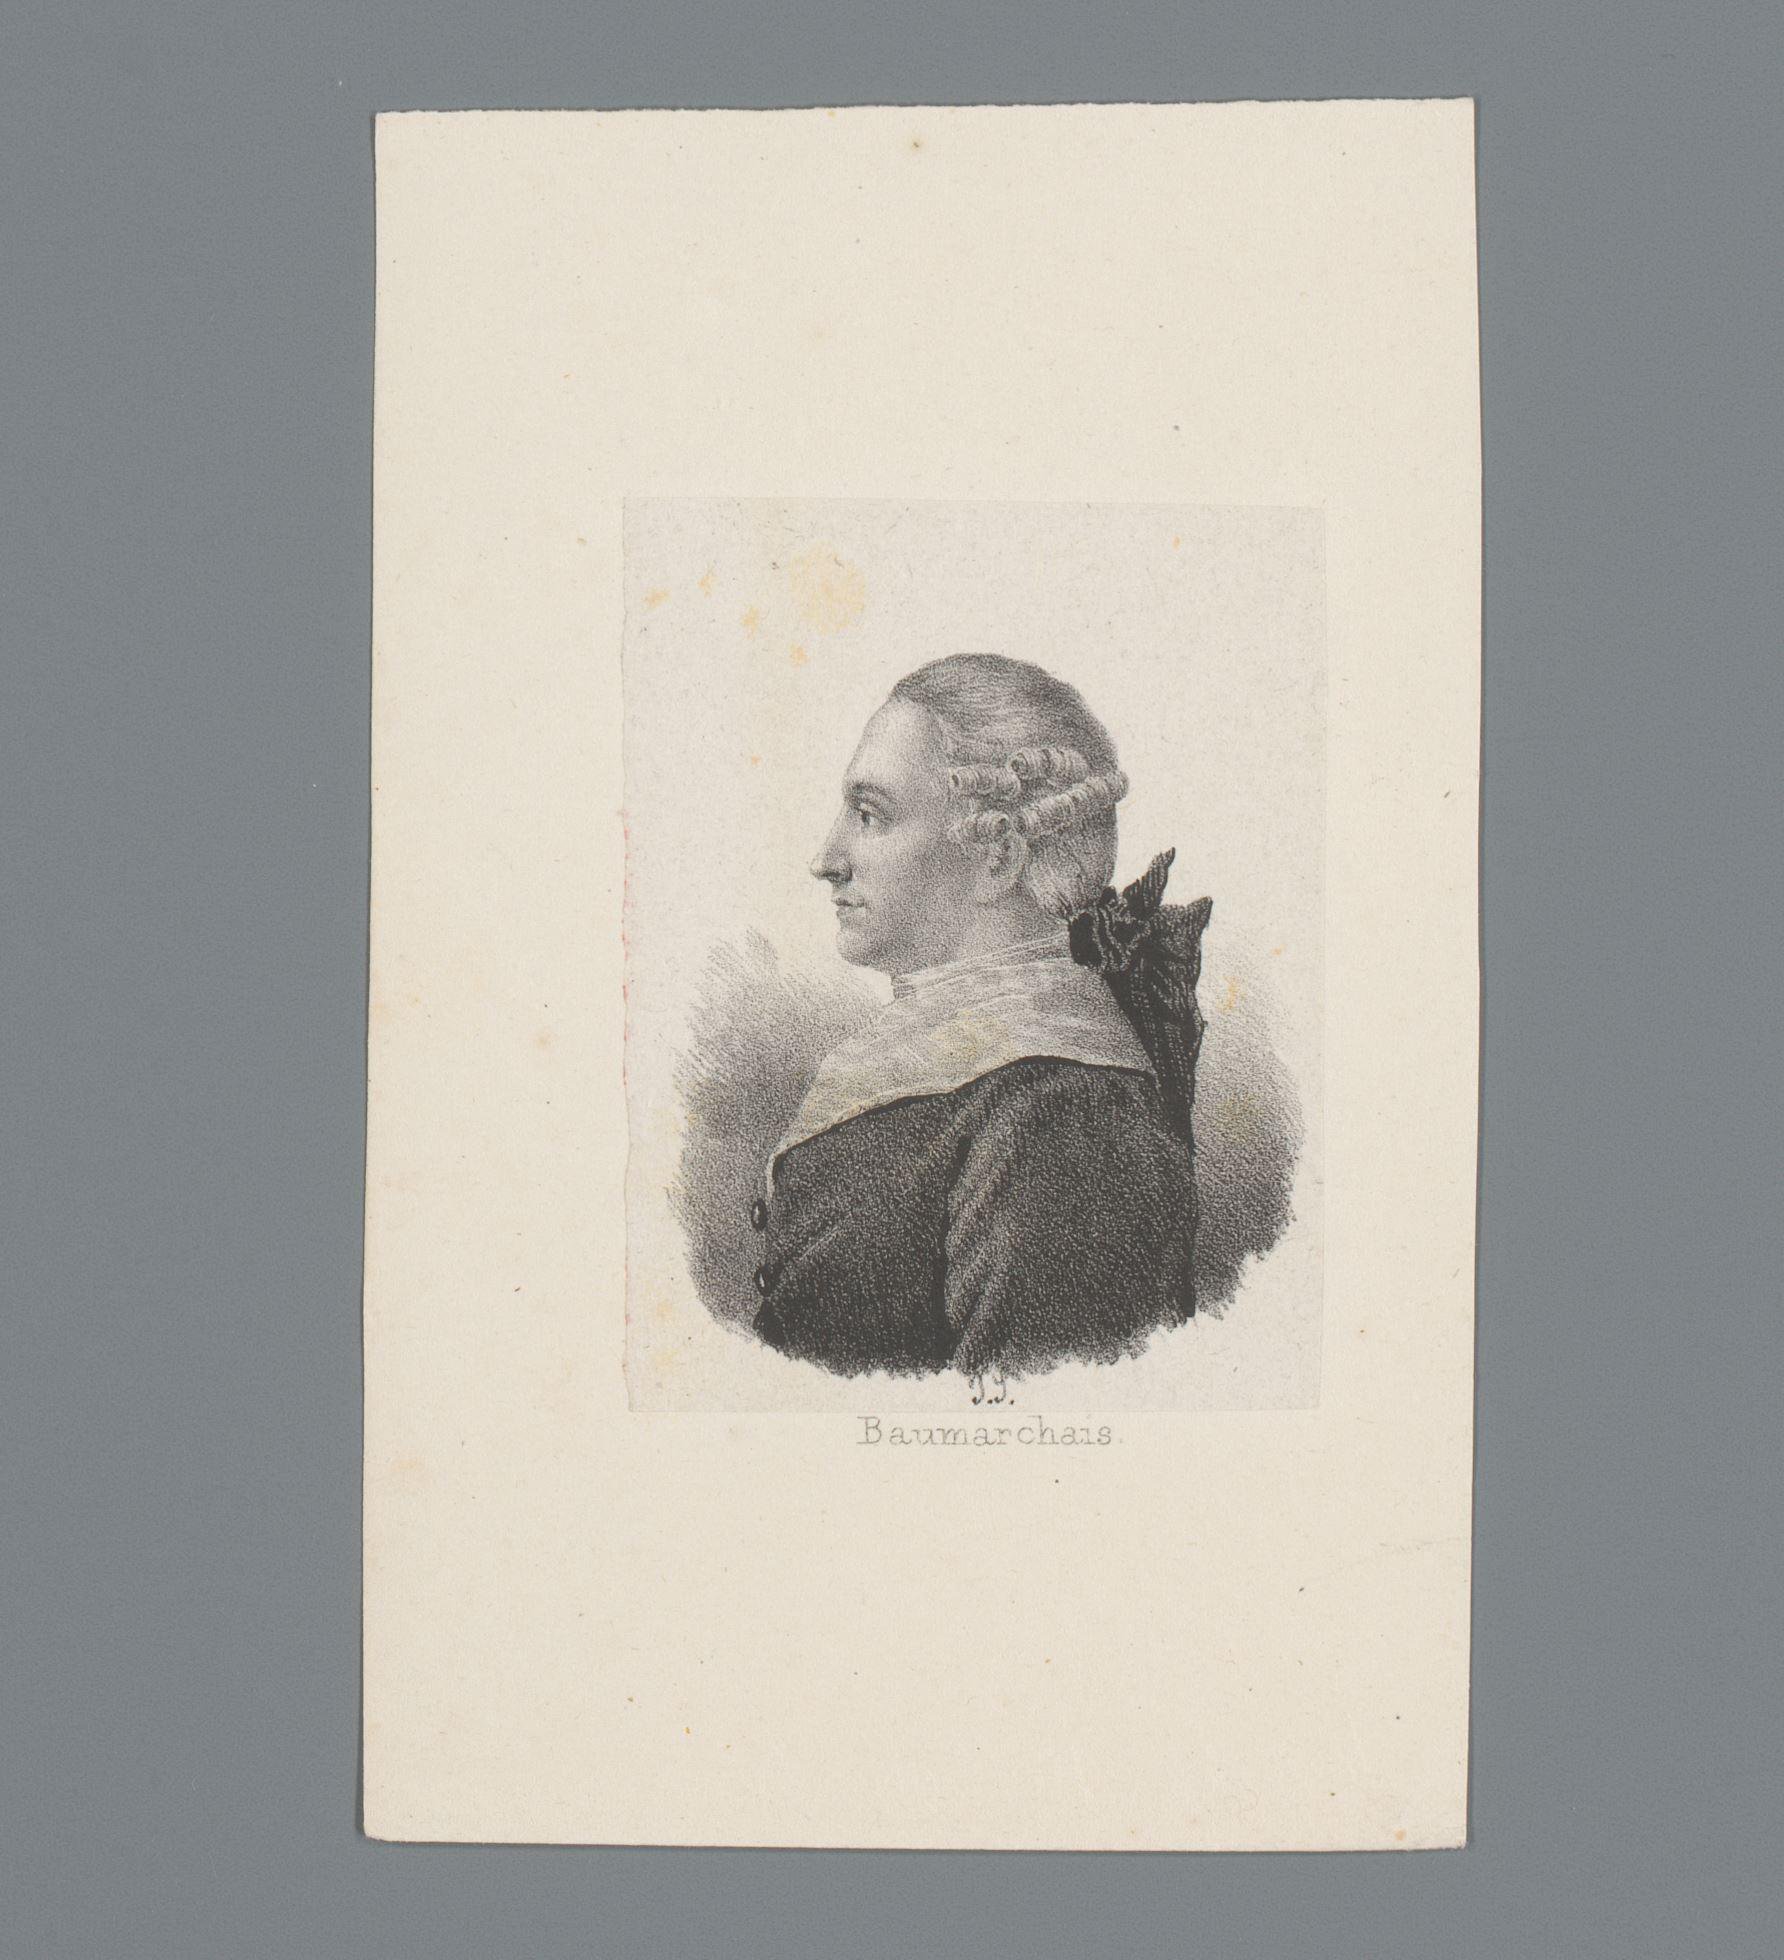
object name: print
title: Portret van Pierre Beaumarchais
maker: joseph schubert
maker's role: print maker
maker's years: 1816-1885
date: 1841-1885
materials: paper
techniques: lithograph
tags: paris, publisher, historical persons, portrait of a writer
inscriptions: collector's mark: Lugt 2228